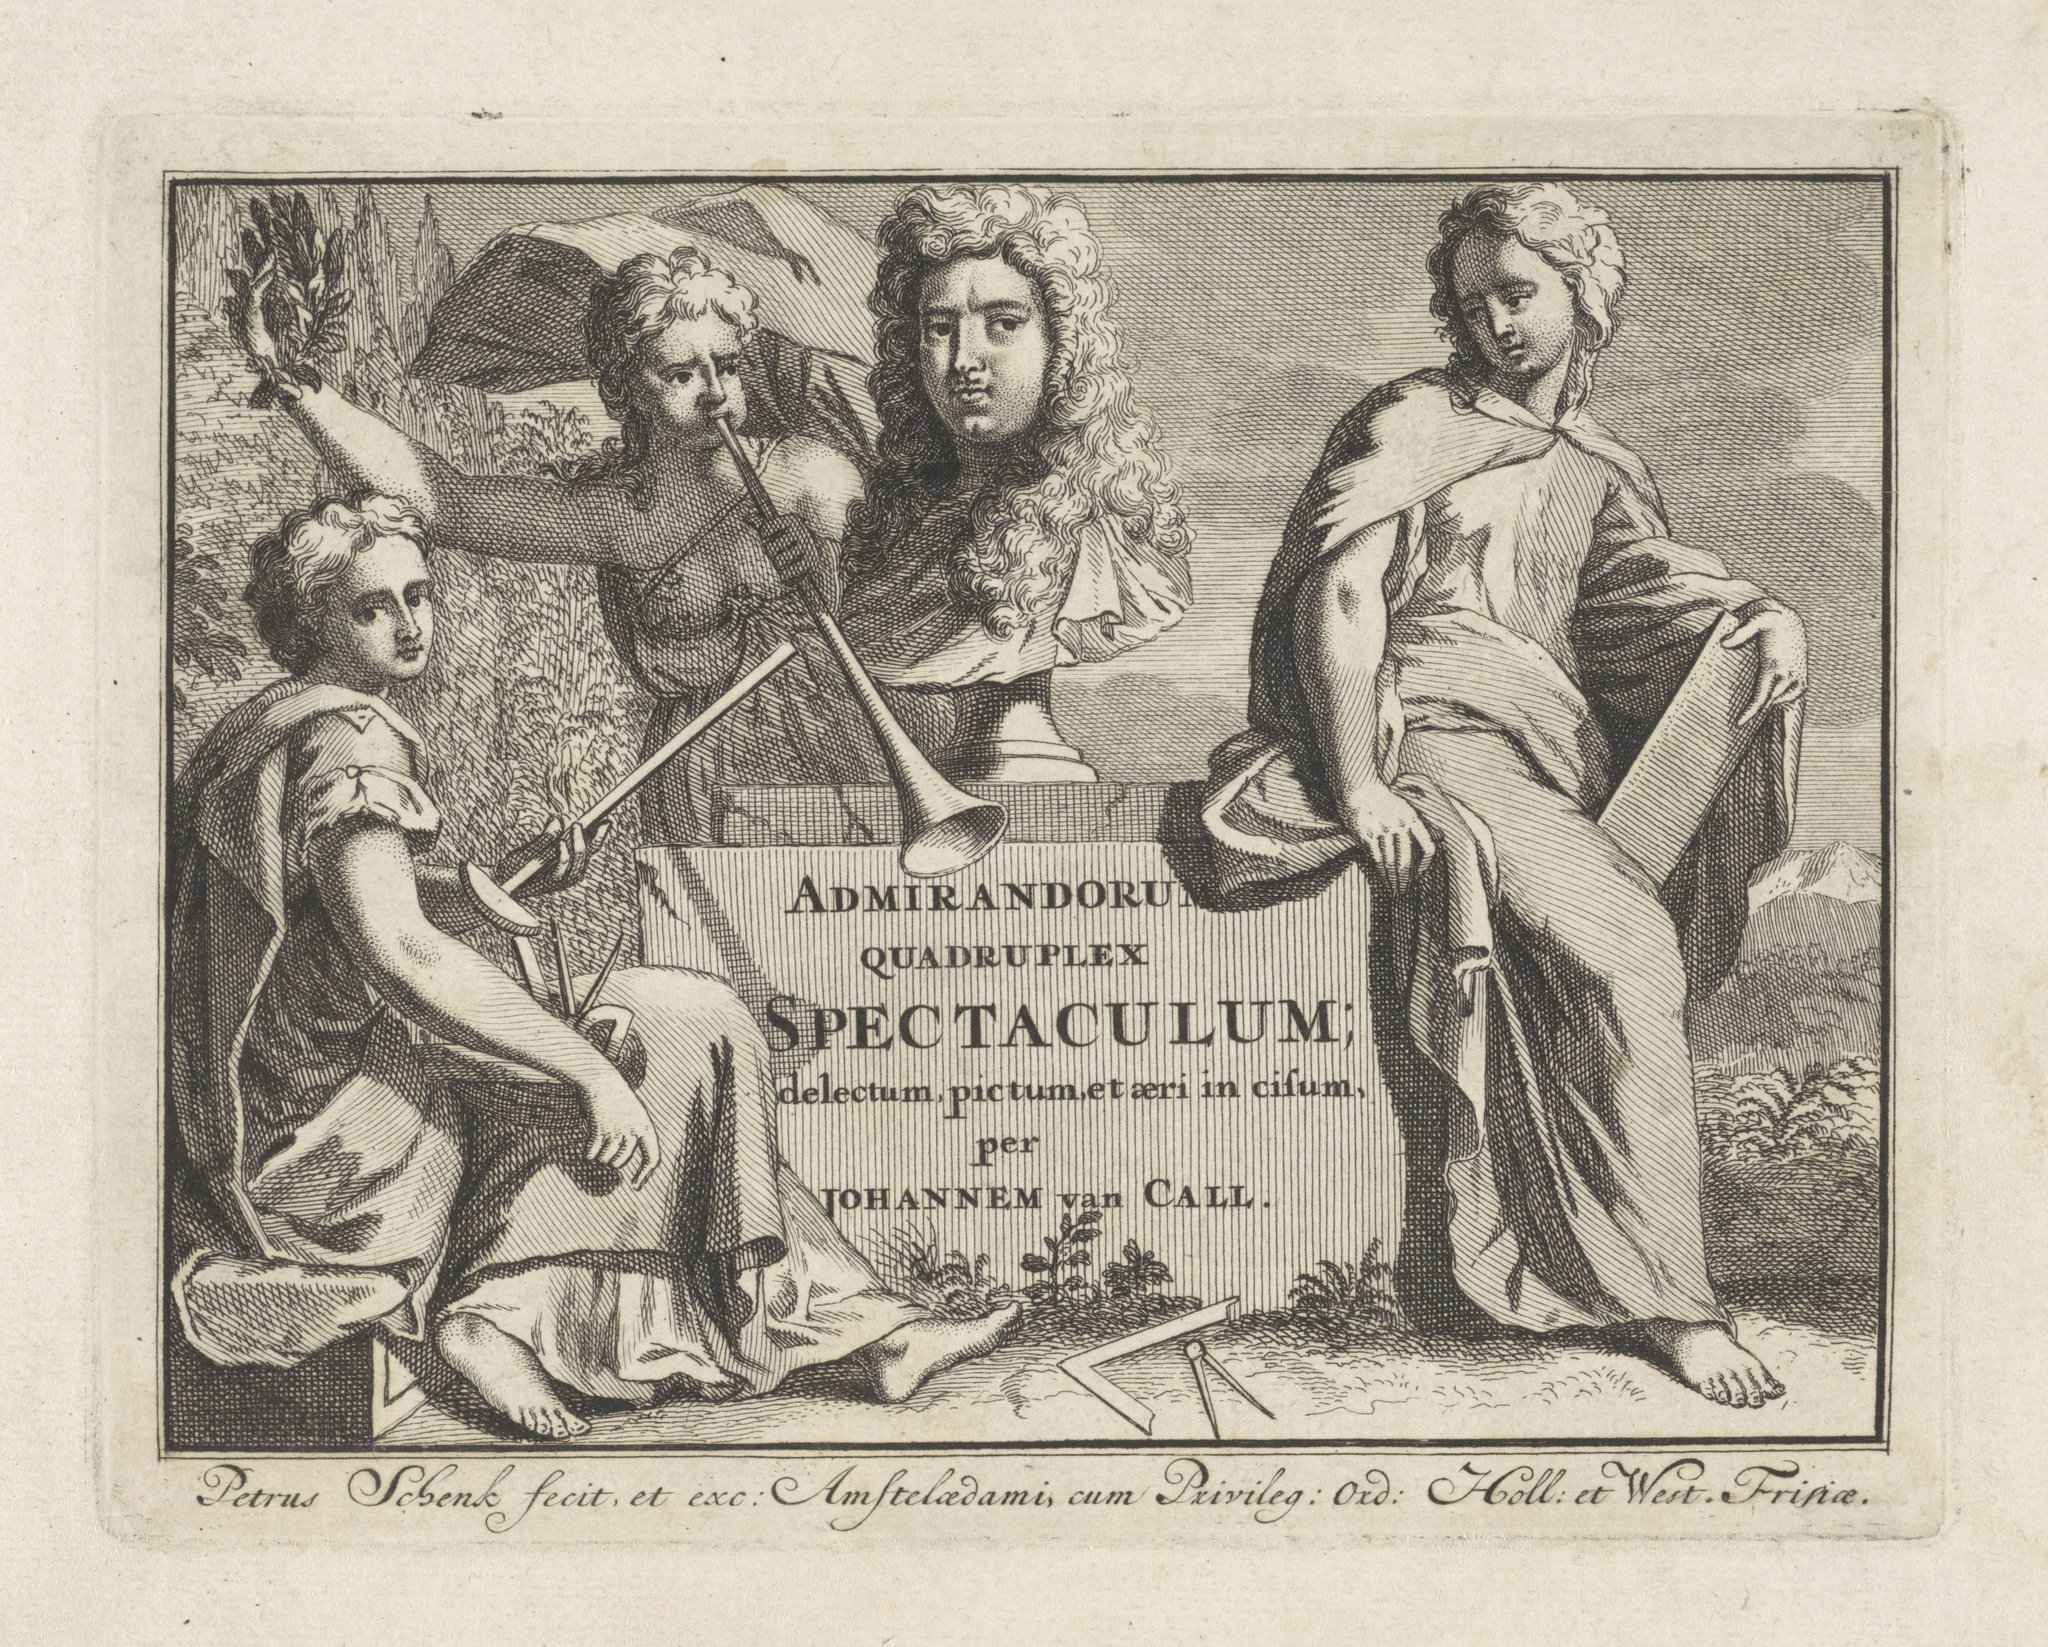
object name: print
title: Admirandorum quadruplex spectaculum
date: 1694-1697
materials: paper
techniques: engraving, etching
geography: amsterdam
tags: nijmegen, the hague, draughtsman, jan van call (i), fame; 'fama', 'fama buona', 'fama chiara' (ripa)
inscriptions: collector's mark: Lugt 2760, collector's mark: Lugt 2228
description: Drie muzen rond een portretbuste van Jan van Call (I). Titelprent voor een serie van 71 prenten met Rijnlandschappen, gezichten op vorstelijke paleizen en stadsgezichten uit Den Haag en Amsterdam.